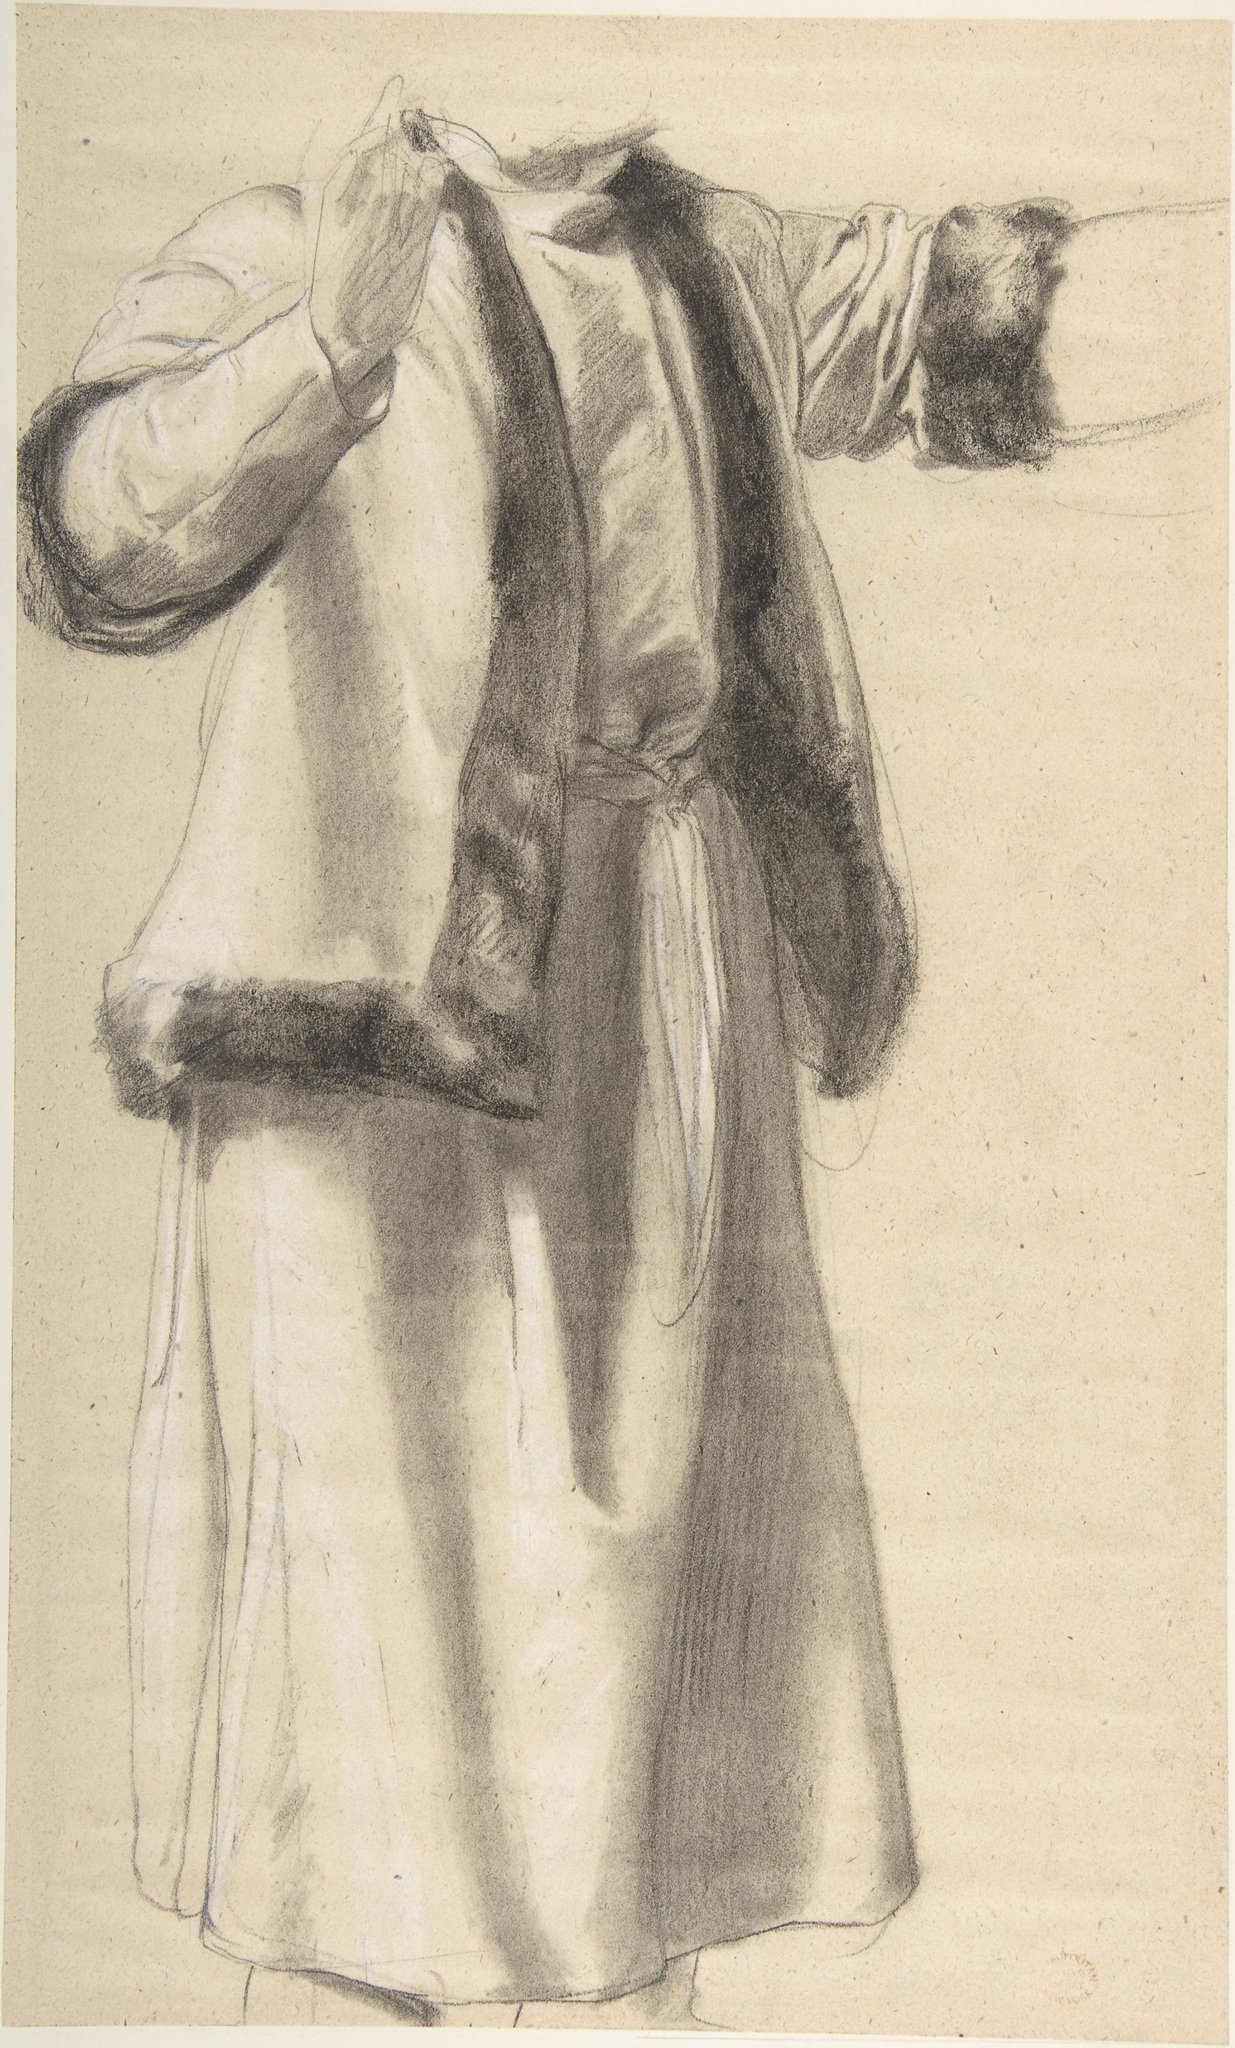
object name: drawing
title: Figure in a Fur Trimmed Jacket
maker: romain cazes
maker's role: artist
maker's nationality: french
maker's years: 1808-1881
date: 1828-1881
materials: chalk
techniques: highlighting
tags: jackets